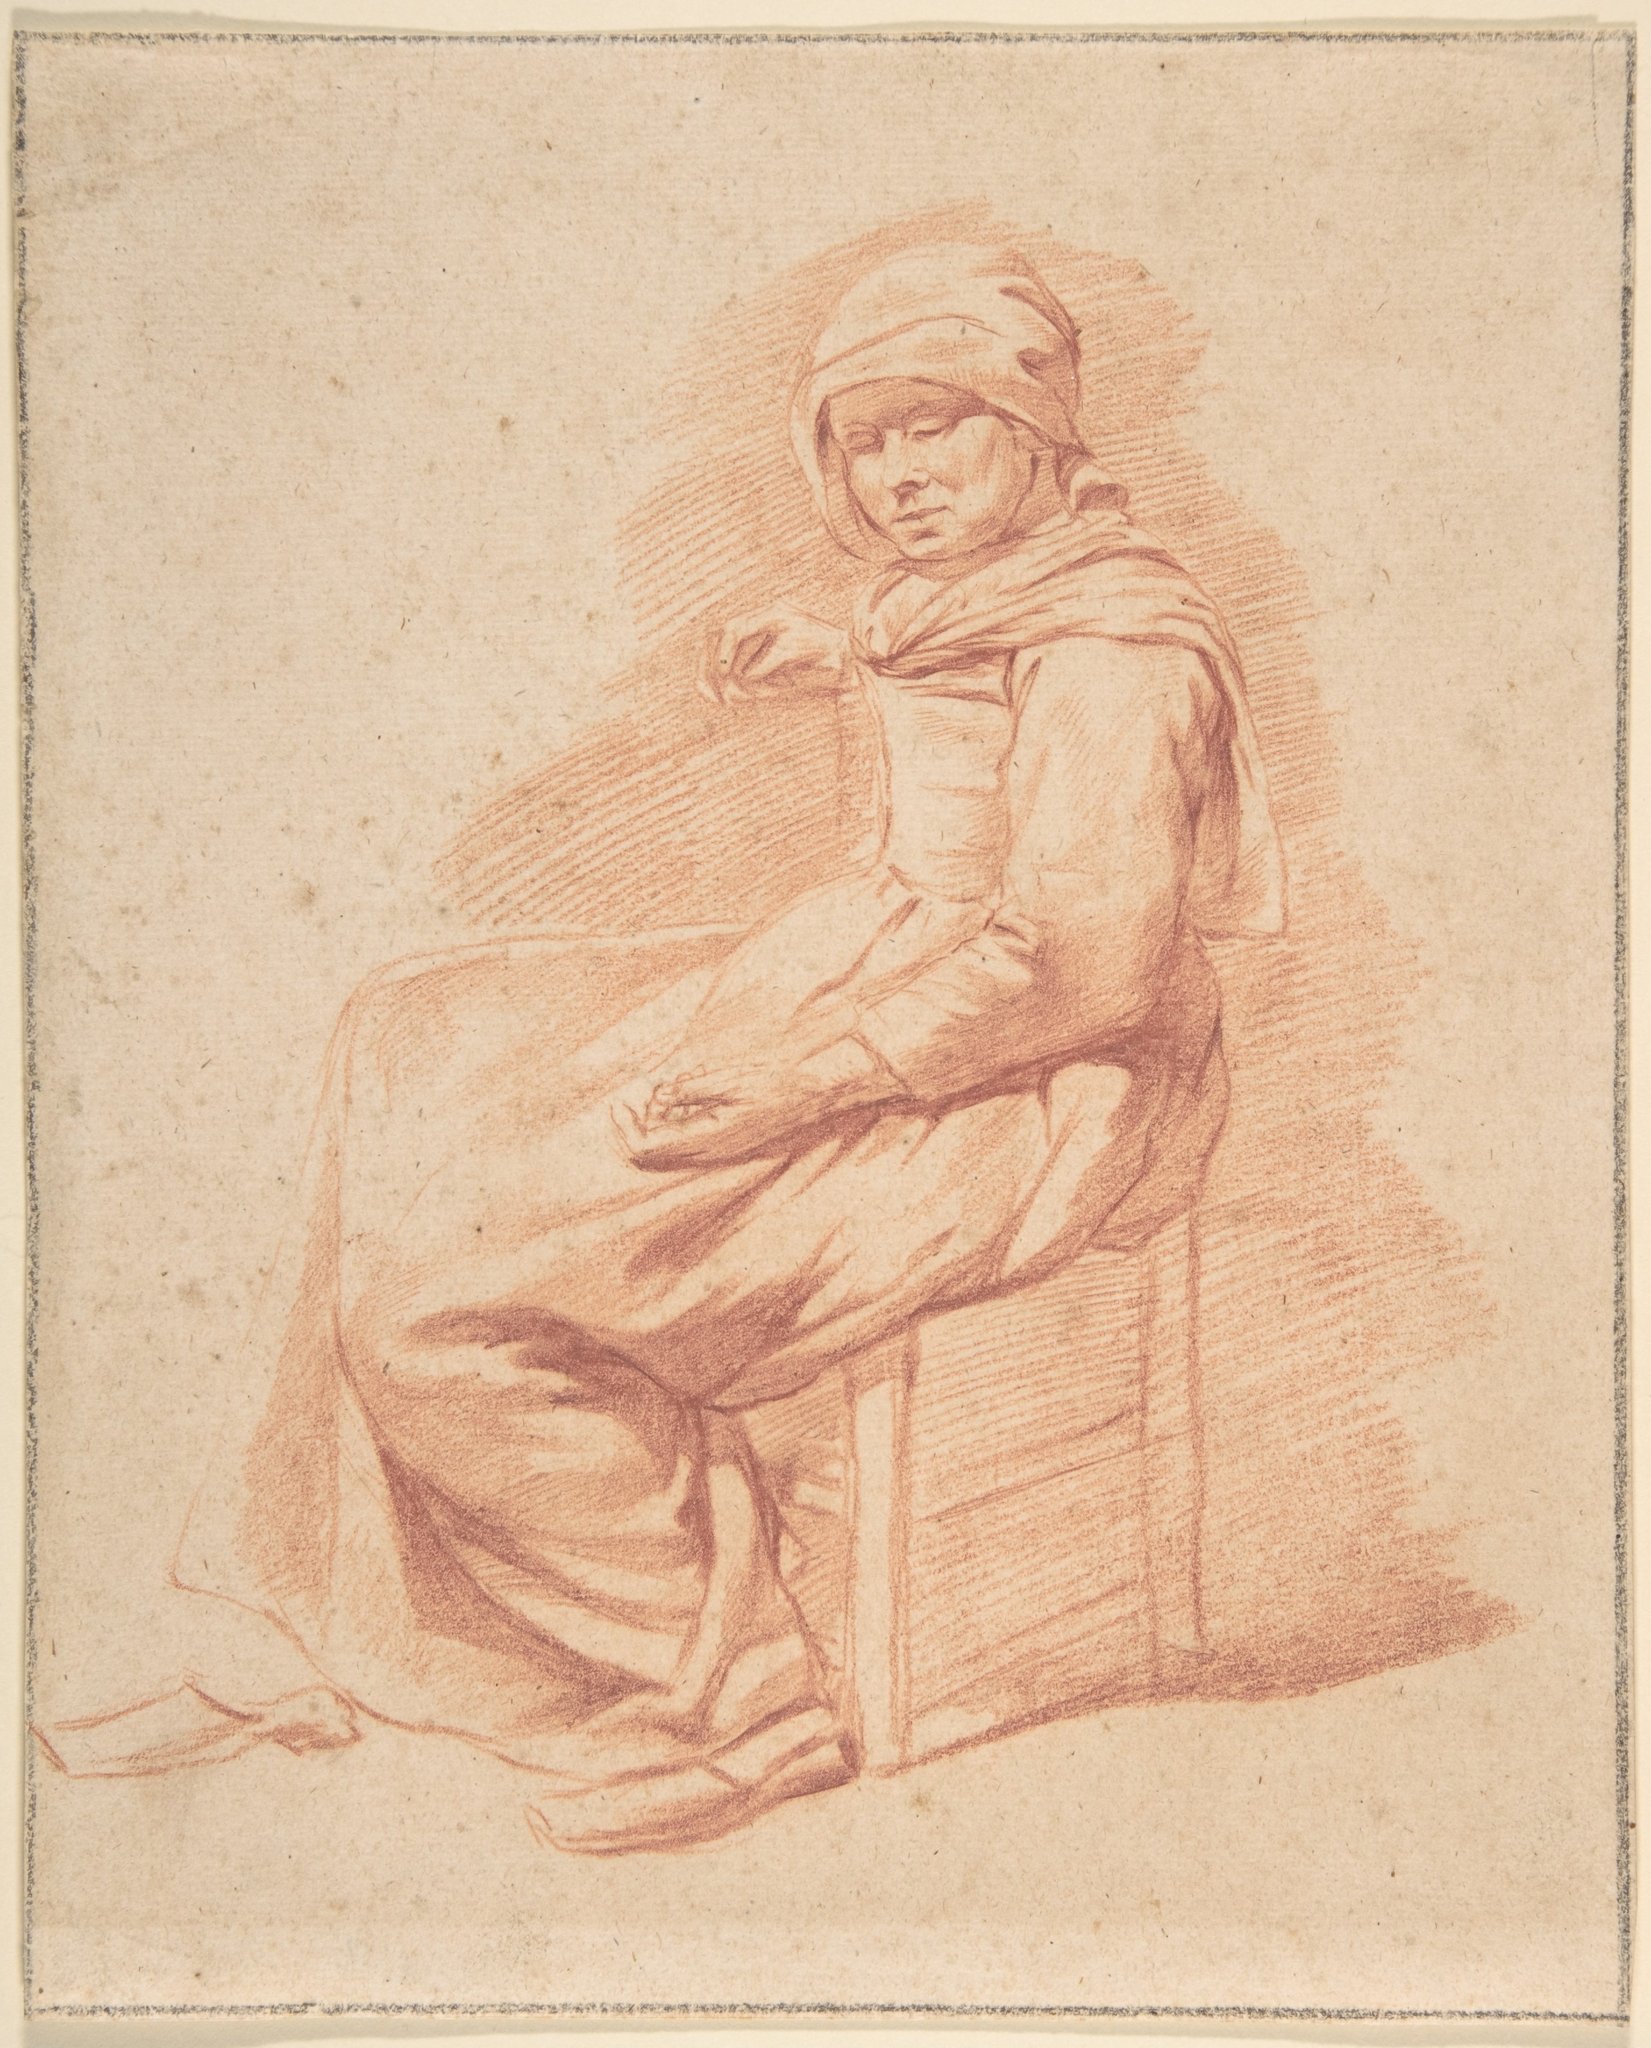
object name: drawing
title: Seated Young Woman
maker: gerrit adriaensz berckheyde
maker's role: artist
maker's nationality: dutch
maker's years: 1638-1698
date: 1601-1700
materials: chalk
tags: women